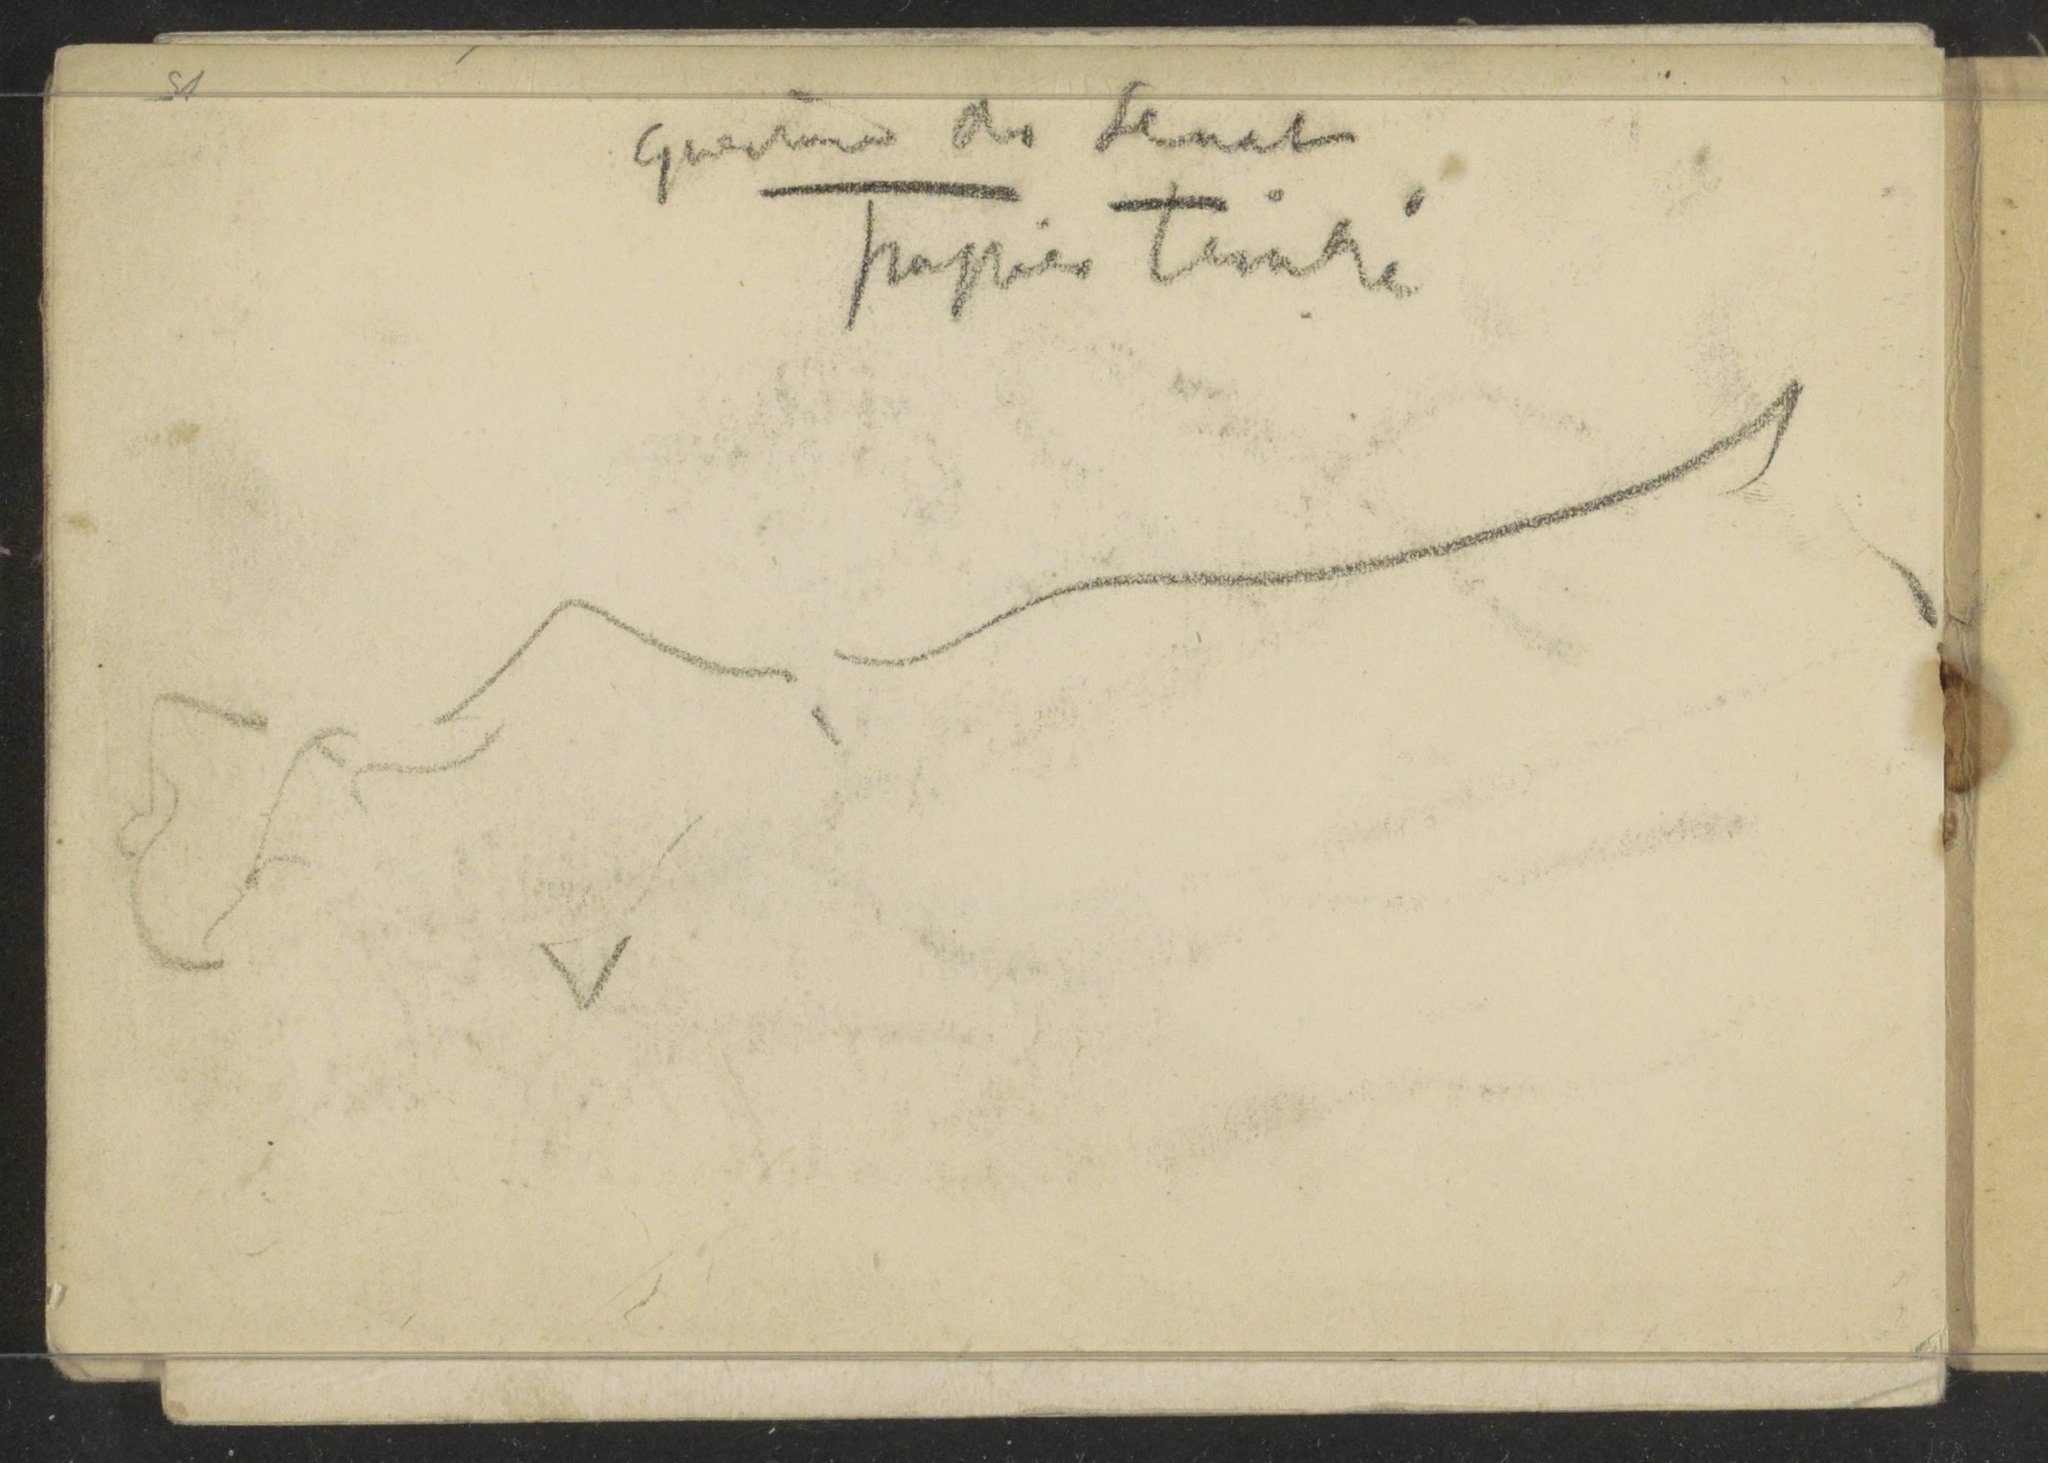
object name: sketchbook leaf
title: Staande vrouw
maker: isaac israels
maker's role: draughtsman, painter, print maker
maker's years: 1865-1934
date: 1923-1934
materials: chalk, paper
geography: the hague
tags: adult woman (+ standing)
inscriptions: annotation: ‘g[...] au[?] senat / papier teinté’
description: Blad 14 verso uit schetsboek LVIII met 14 bladen.